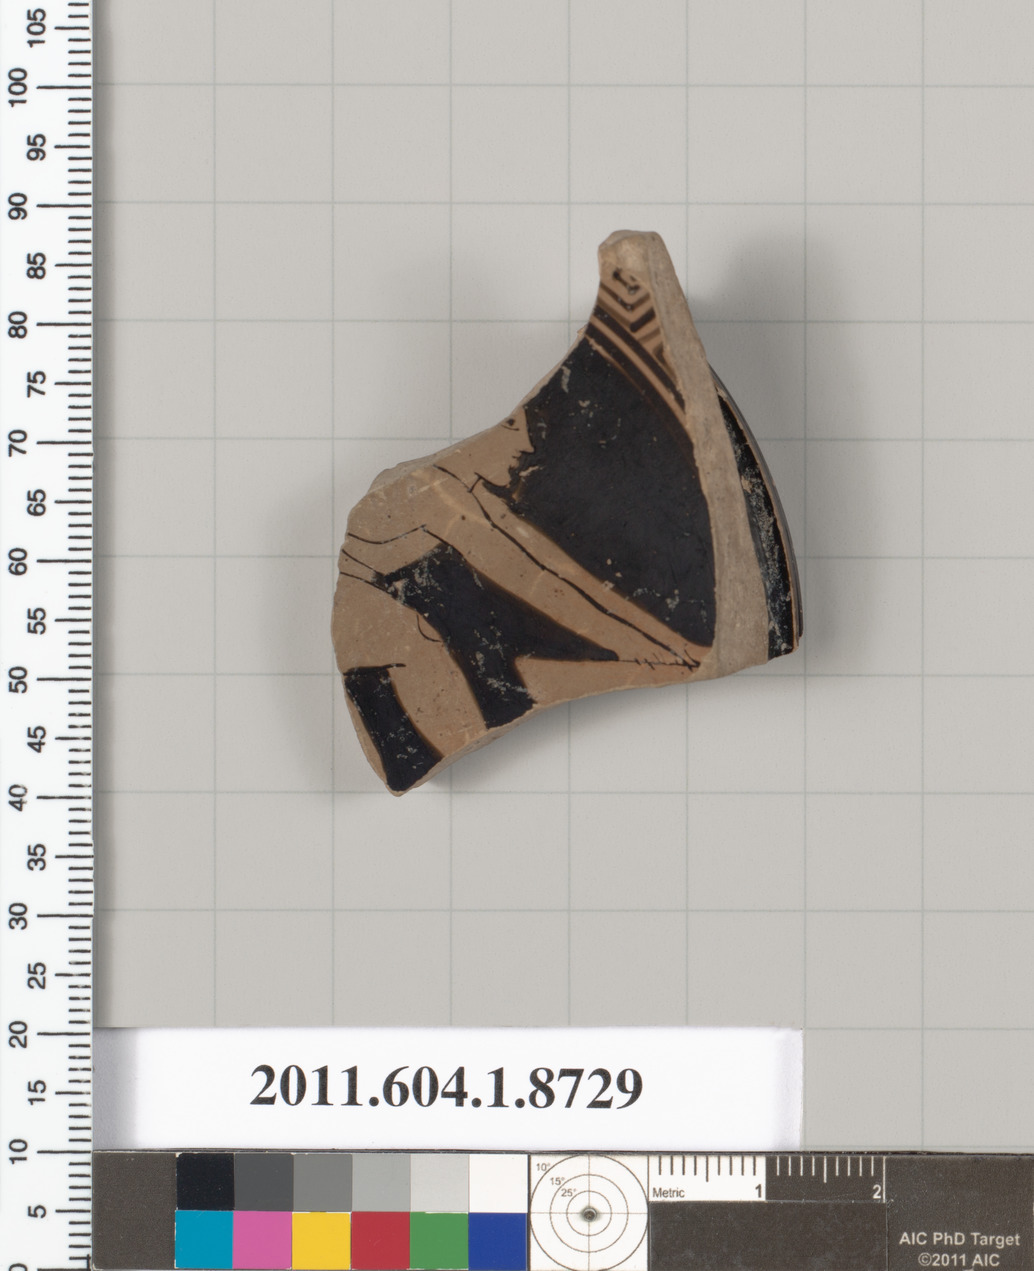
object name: kylix fragment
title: Terracotta fragment of a stemless cup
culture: greek, attic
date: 480-470 BCE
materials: terracotta